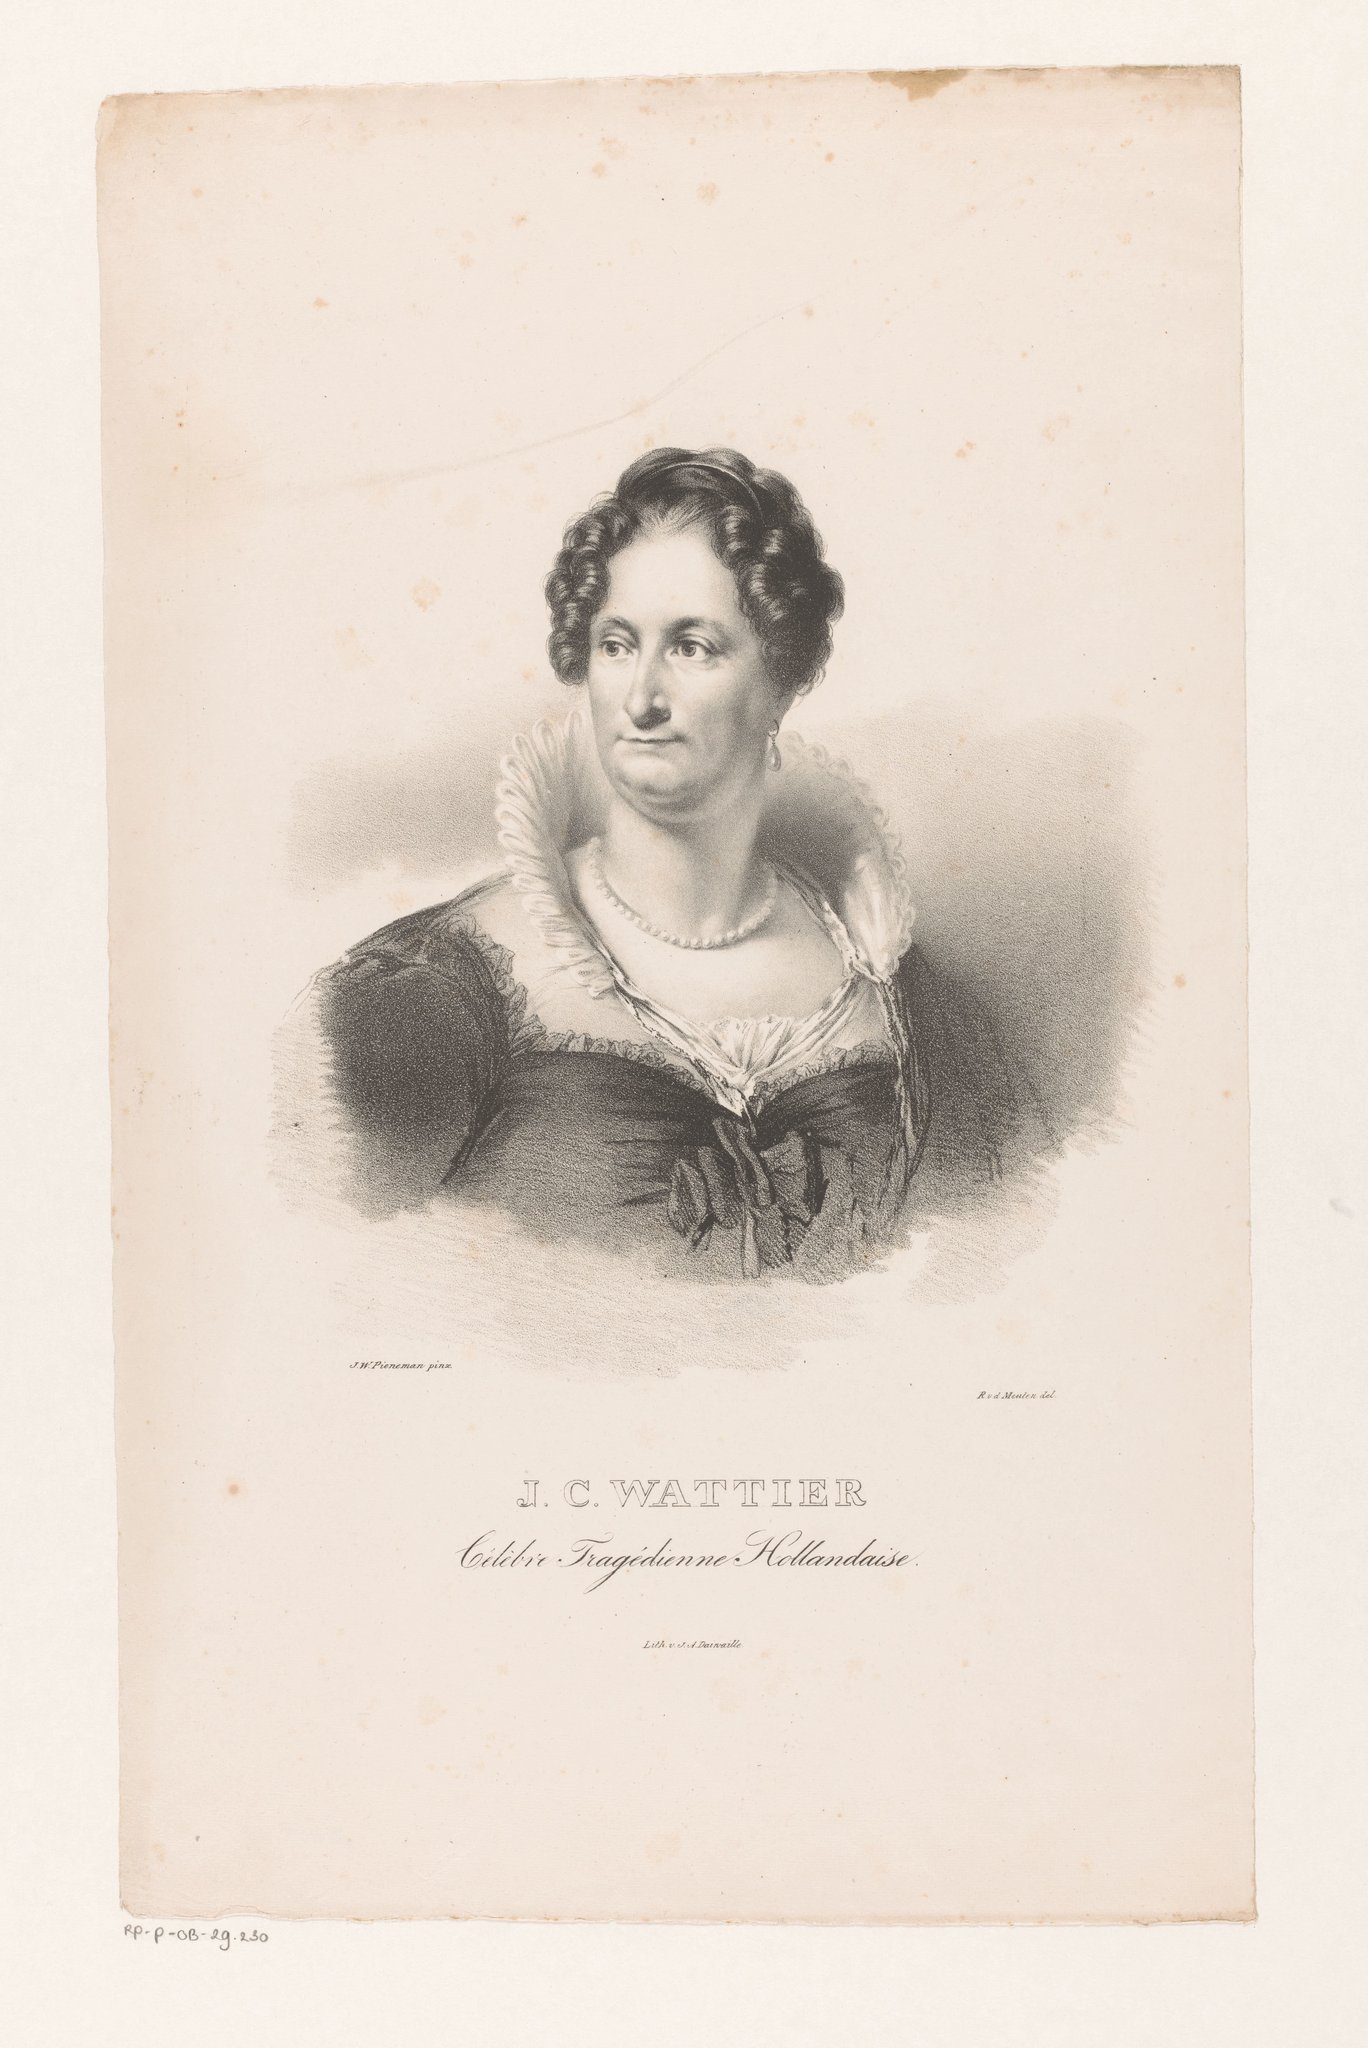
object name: print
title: Portret van Johanna Cornelia Wattier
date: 1816-1833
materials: paper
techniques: lithograph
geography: amsterdam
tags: historical persons - bb - woman (+ (full) bust portrait)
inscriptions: collector's mark: Lugt 2228